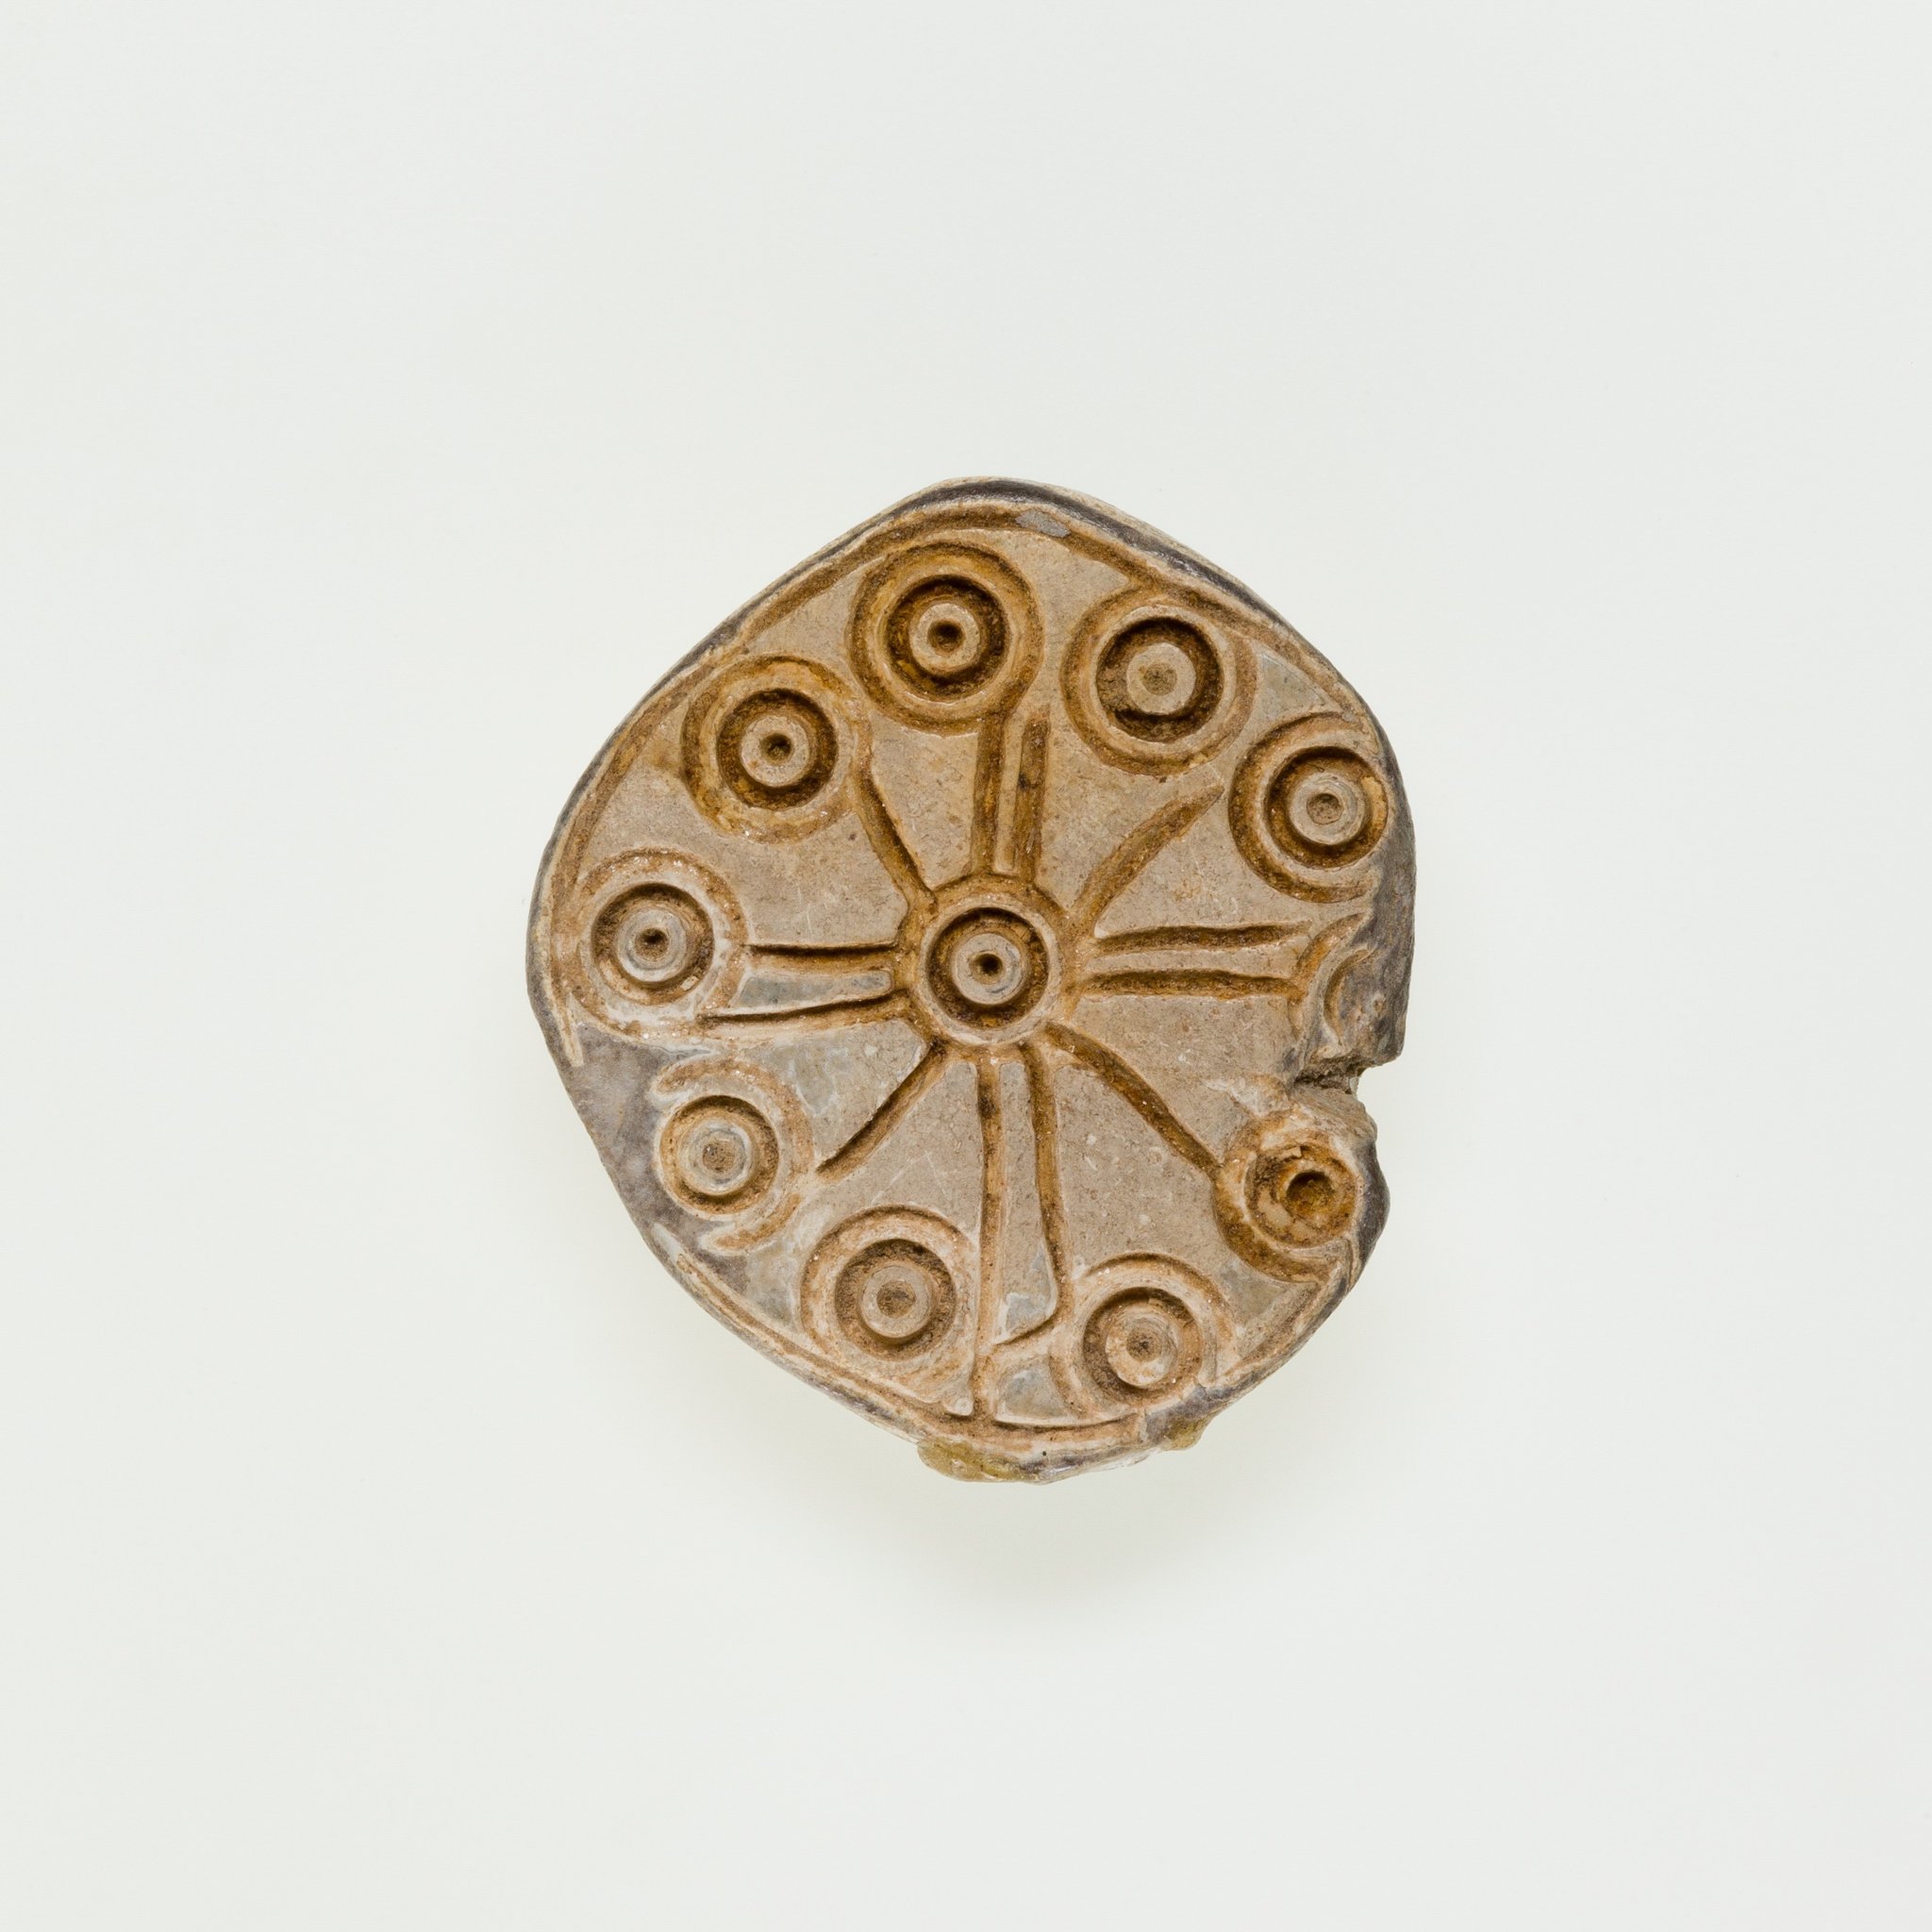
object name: scarab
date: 1981-1295 BCE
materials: stone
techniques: glazing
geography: egypt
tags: scarabs